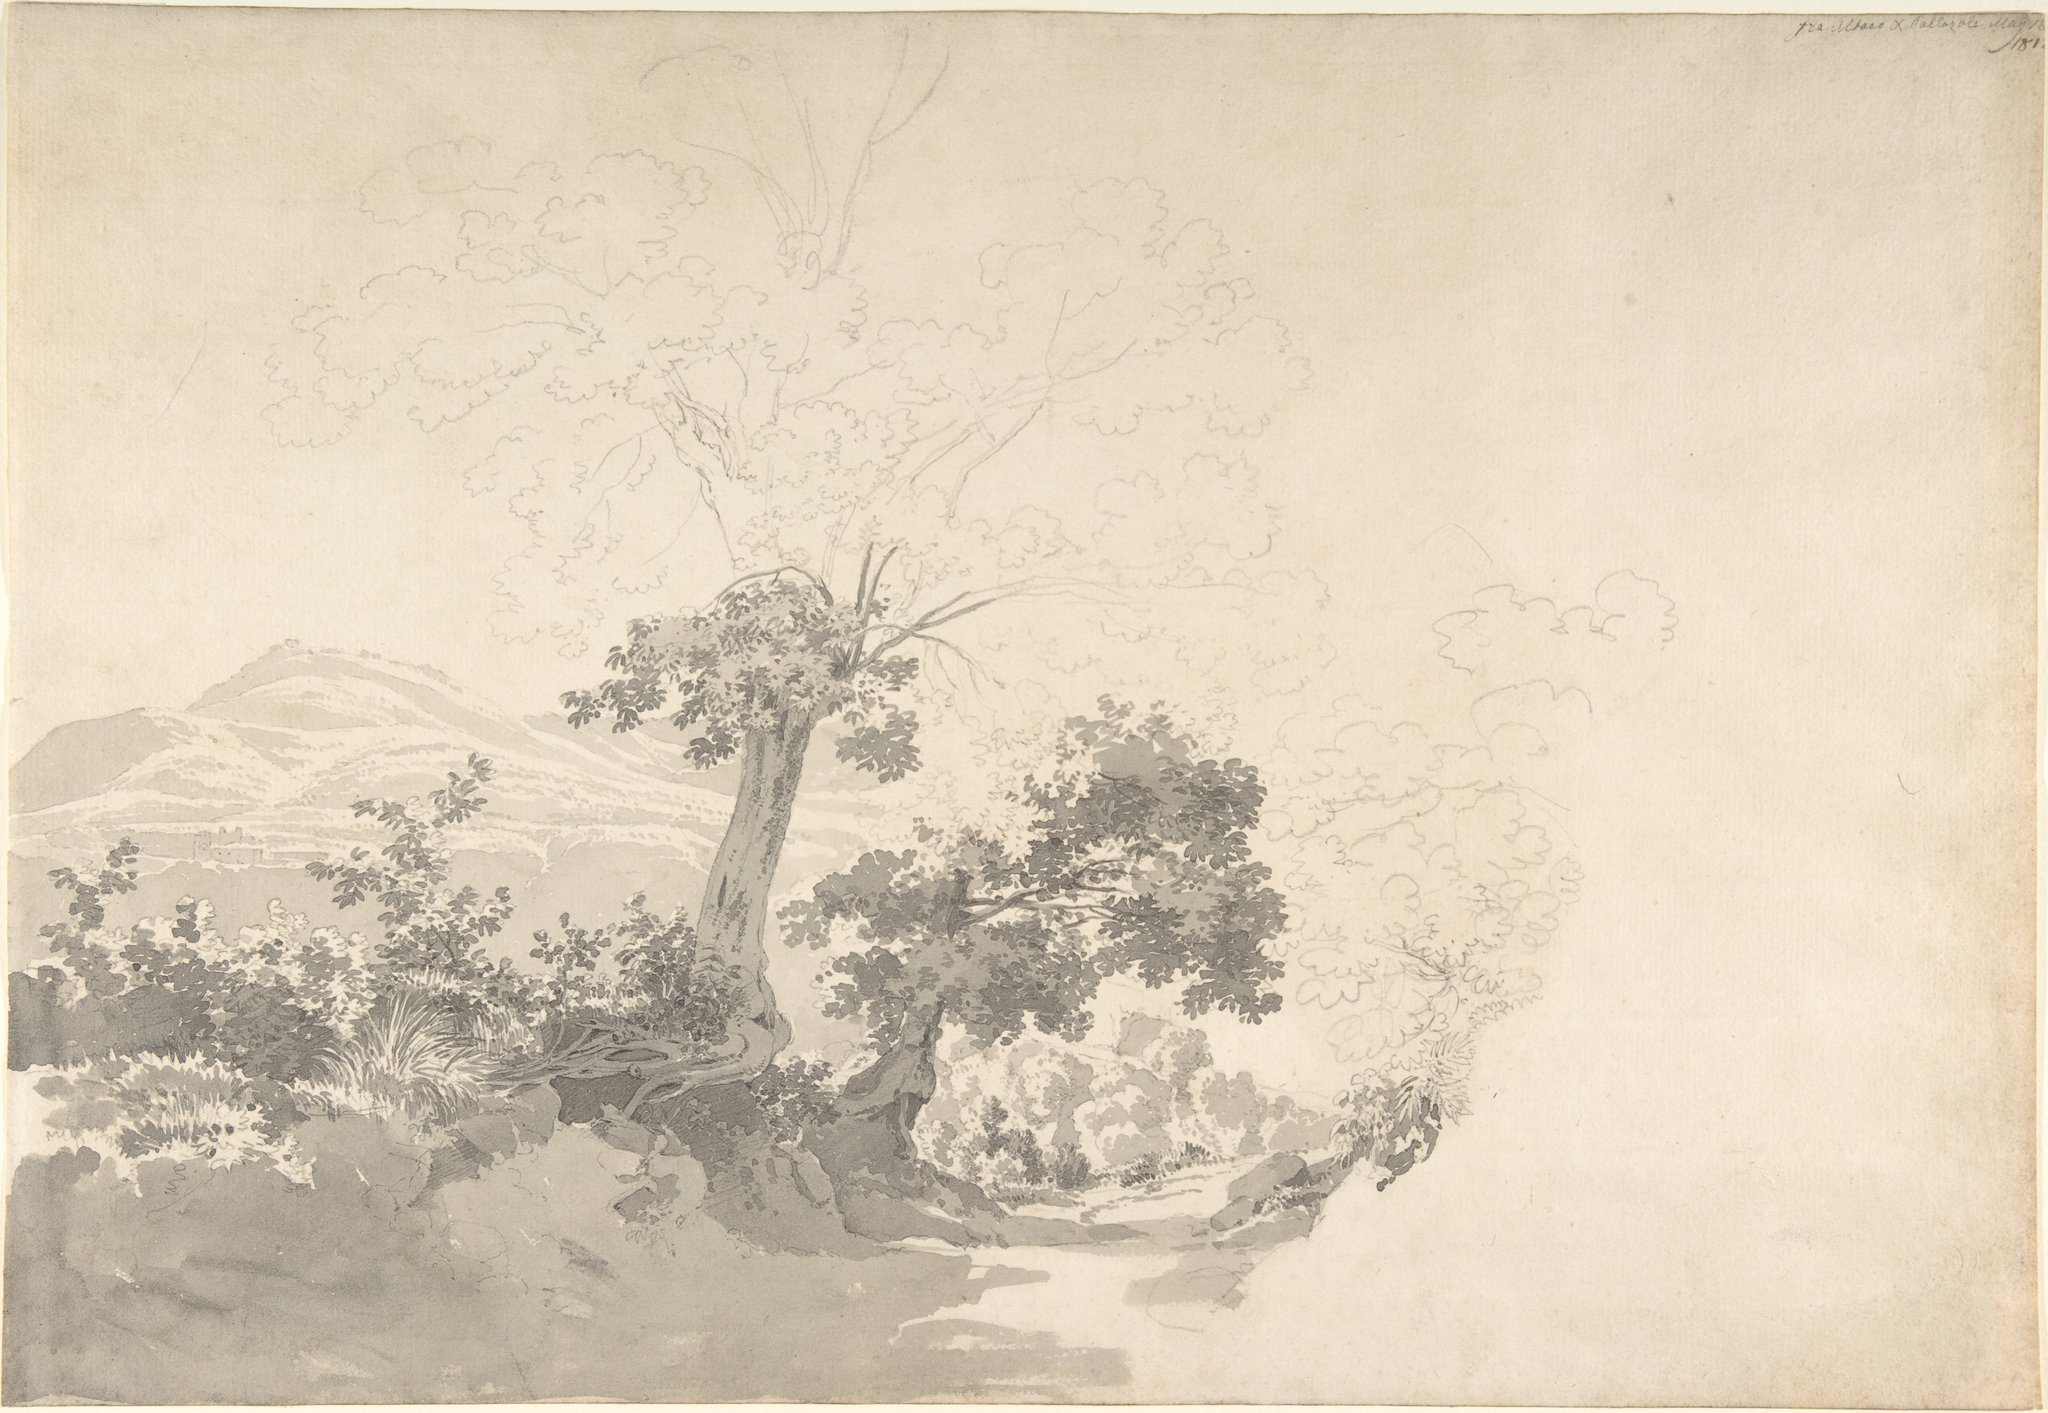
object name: drawing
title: Landscape near Albano and Pallazole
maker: joseph rebell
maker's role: artist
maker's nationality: austrian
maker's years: 1786-1828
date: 1812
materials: graphite, ink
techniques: pen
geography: austria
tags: mountains,landscapes,trees